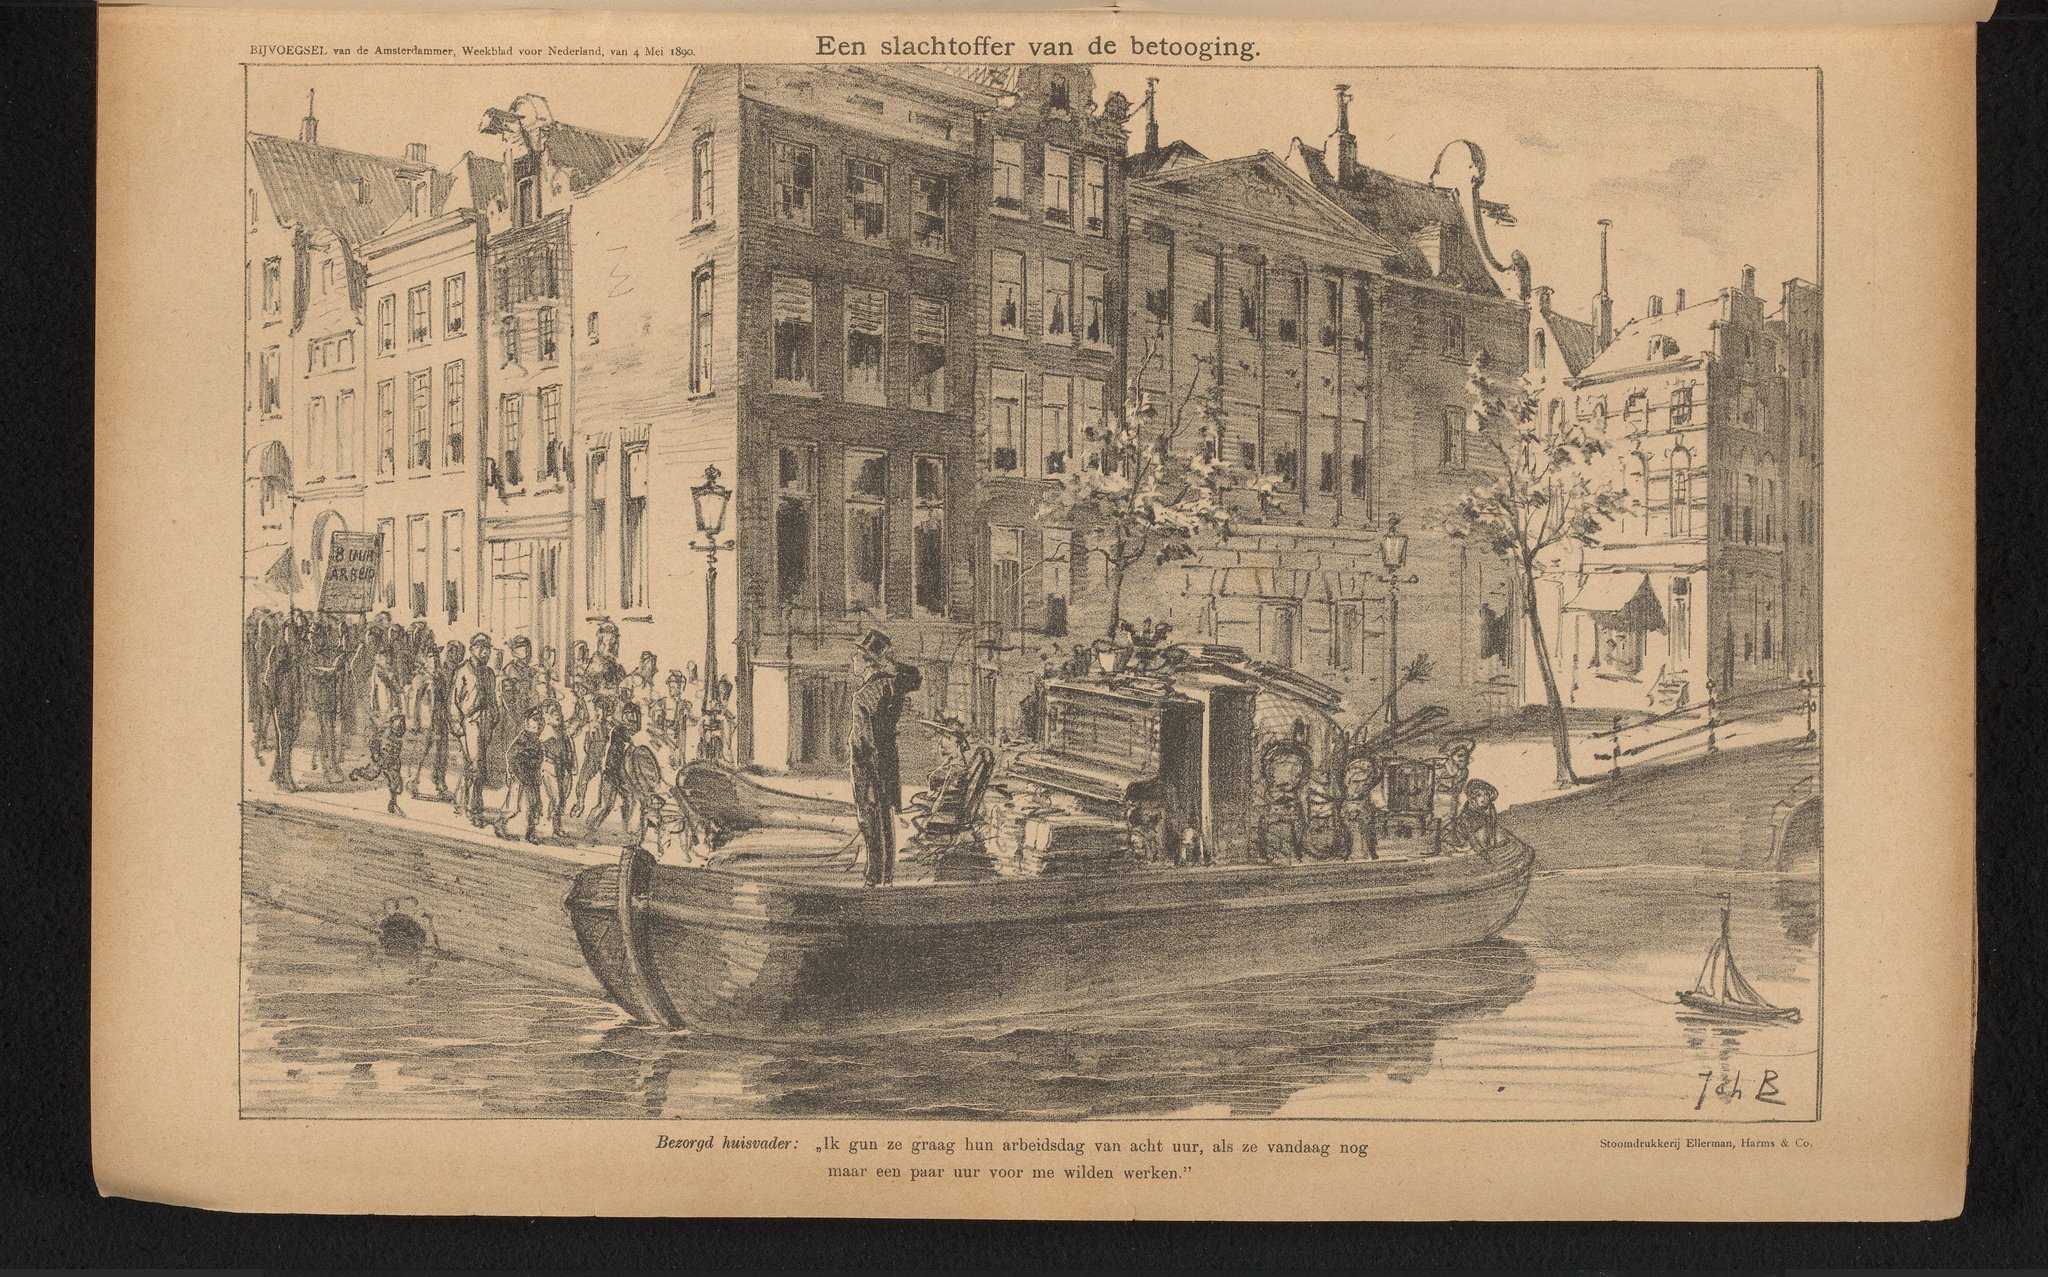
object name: cartoon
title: Een slachtoffer van de betooging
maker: johan braakensiek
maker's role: draughtsman, print maker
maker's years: 1858-1940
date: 1890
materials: paper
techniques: lithograph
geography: netherlands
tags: political demonstration, working class, labourers, houseboat, political caricatures and satires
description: Een man met zijn gezin op een woonboot ziet op straat de betoging voor een achturige werkdag.